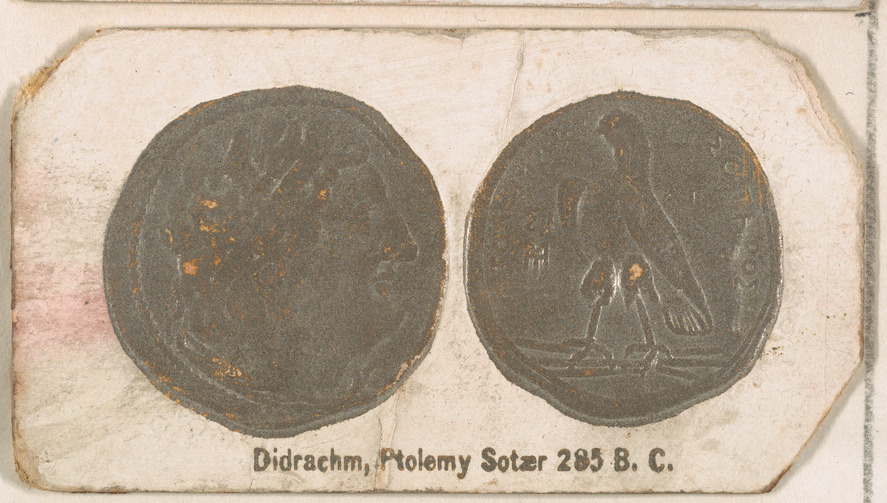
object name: print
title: Didrachm Ptolemy Sotaer, 285 B.C., from the Ancient Coins series (N180) issued by Wm. S. Kimball & Co.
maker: william s. kimball & company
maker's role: publisher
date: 1888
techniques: color lithograph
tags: coins